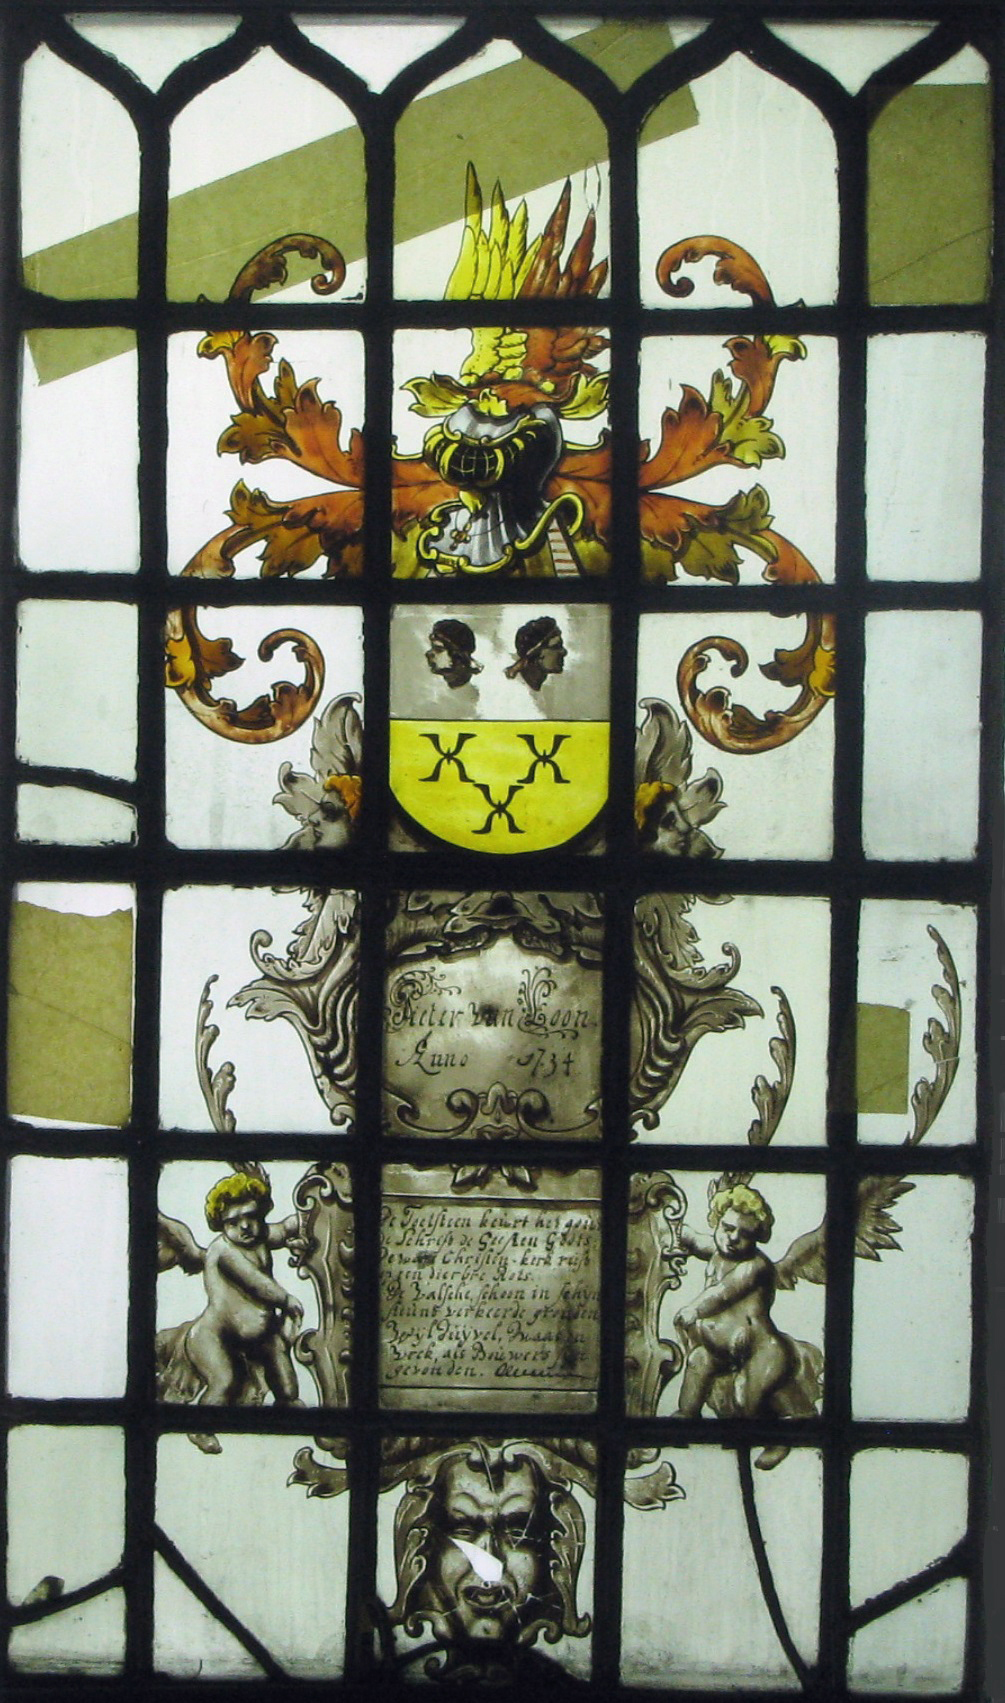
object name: armorial window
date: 1734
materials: glass